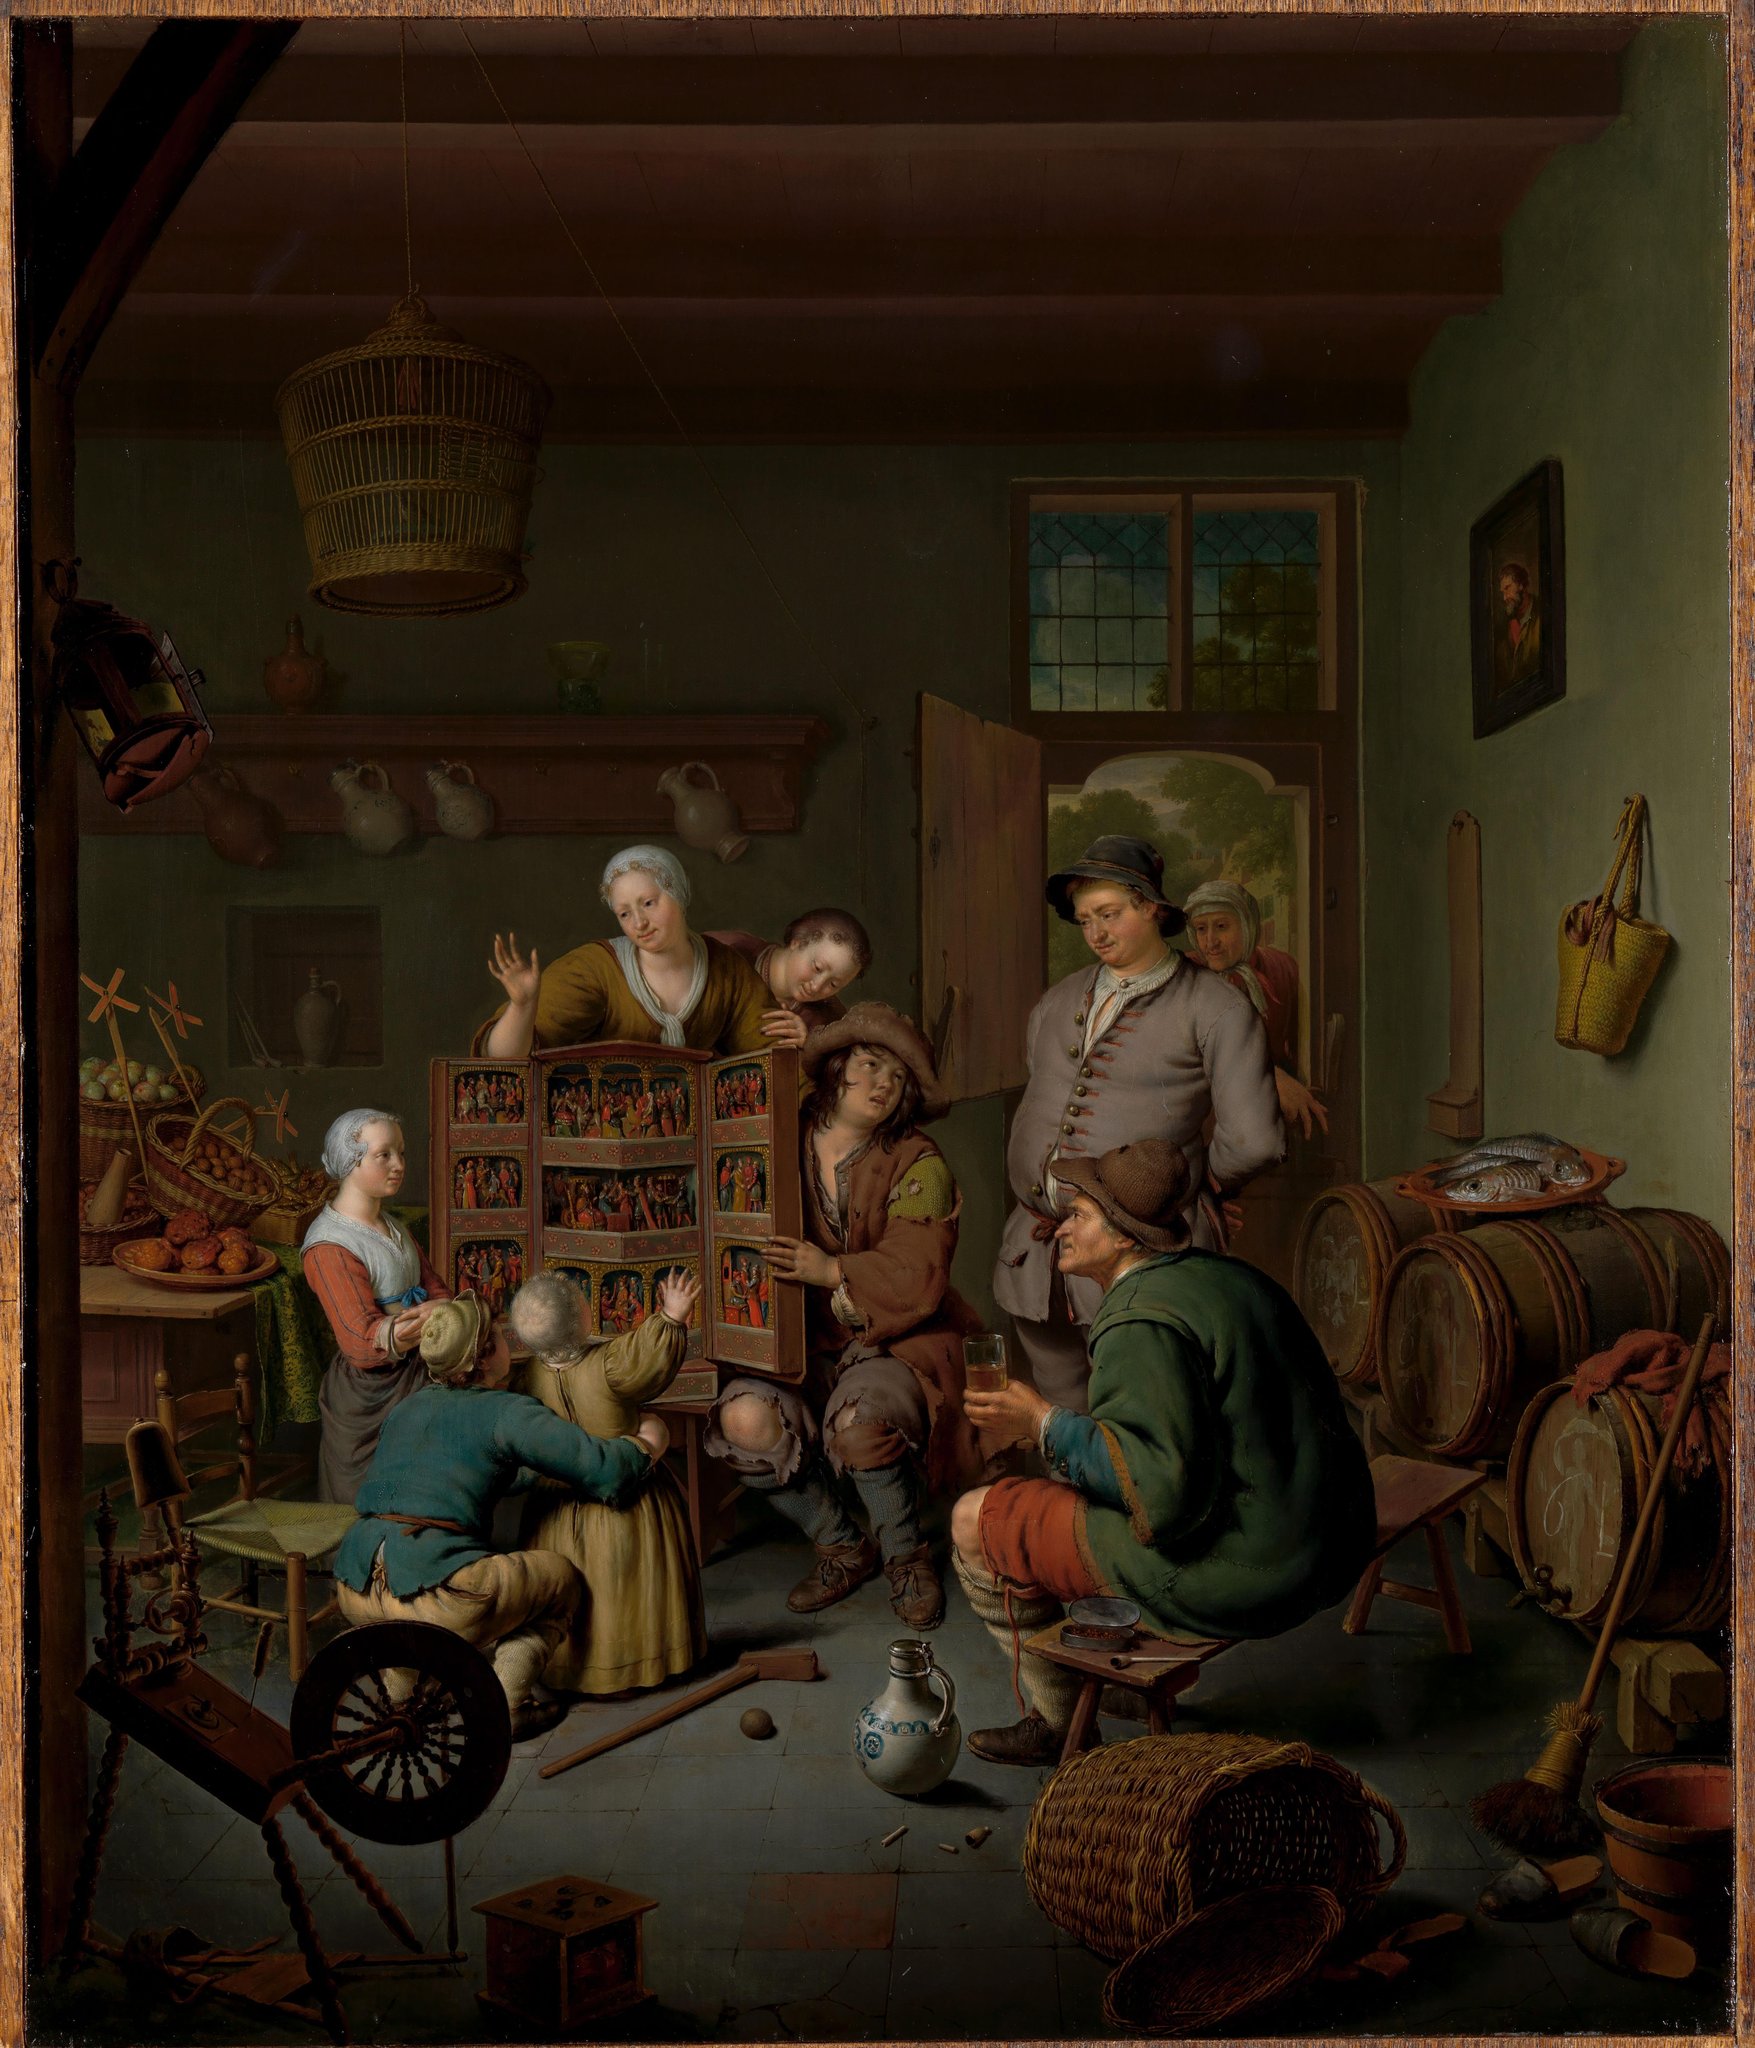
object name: painting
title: The Raree-show (’t Fraay Curieus)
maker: willem van mieris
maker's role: draughtsman, painter, print maker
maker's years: 1662-1747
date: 1718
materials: oil, panel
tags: child and art, minstrel, 'jongleur', fishes, 'fahrende leute', vagrants, interior of the house, peep-show, bird in a cage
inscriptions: signature and date: ‘W. Van Mieris Fec Ano 1718’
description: The old Dutch title (in parentheses) refers to the cries ‘beautiful!’ (fraai) and ‘extraordinary!’ (curieus) with which itinerant performers announced themselves. Here a performer shows a wooden triptych with characters from a chivalric romance, while undoubtedly recounting the tale to those gathered around. Willem van Mieris was a ‘fine painter’, meaning that he rendered the scene in a highly detailed and refined manner. The painting is actually also a kind of peepshow.